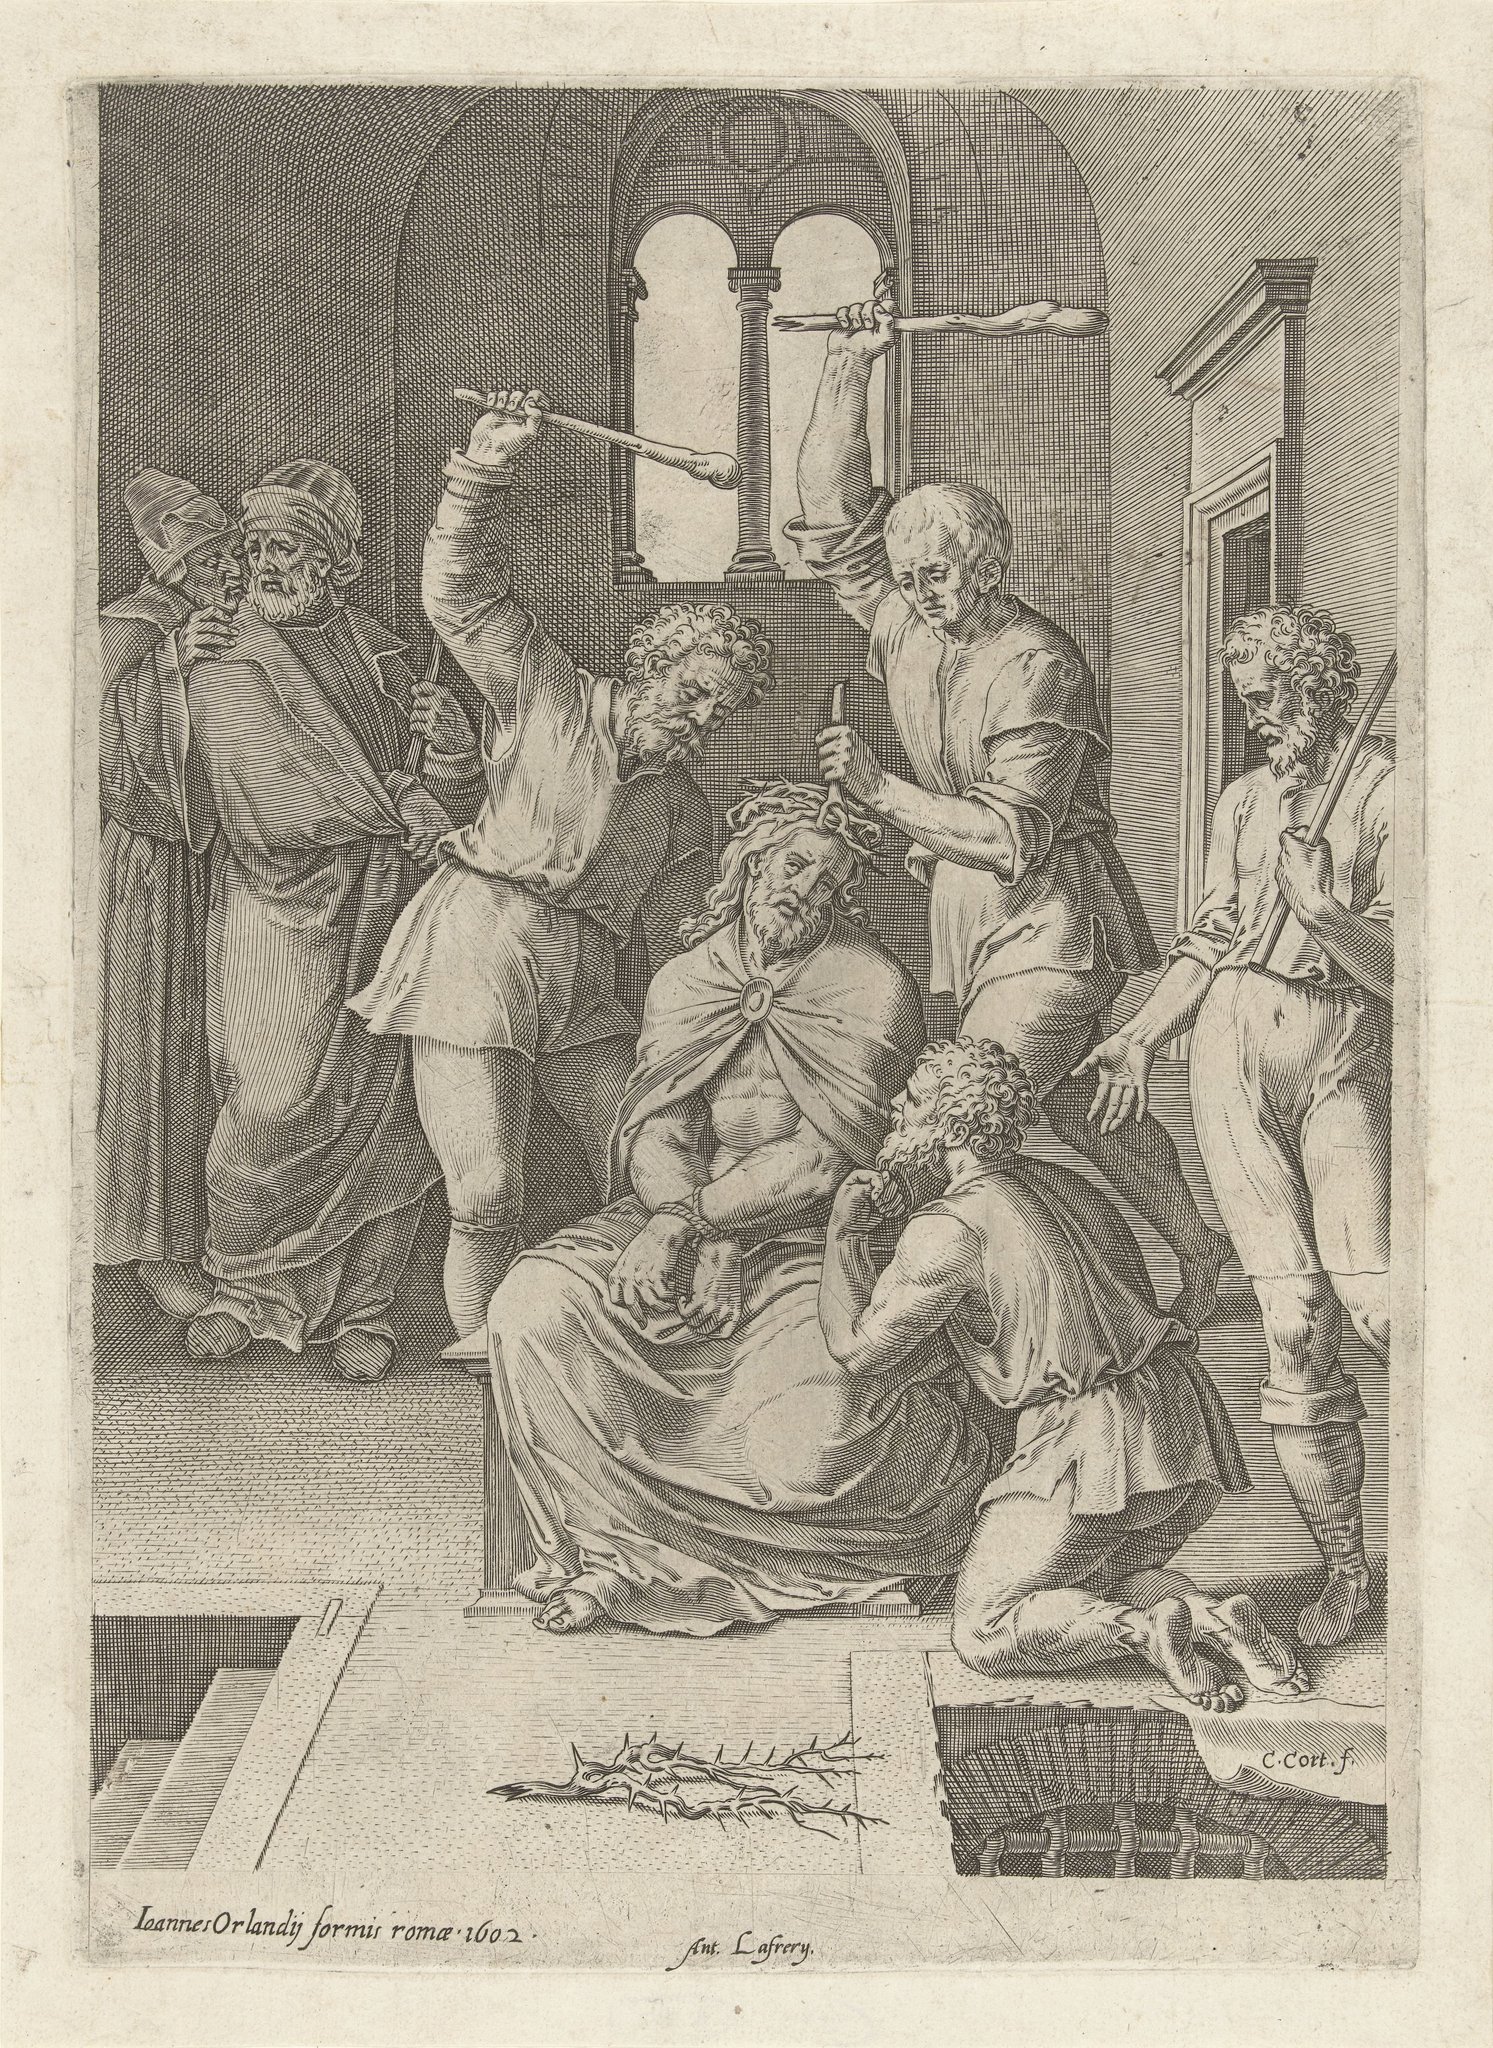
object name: print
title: De doornenkroning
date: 1602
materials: paper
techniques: engraving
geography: rome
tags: the crowning with thorns: soldiers with sticks place a thorny crown on christ's head and give him a reed (matthew 27:27-31; mark 15:16-20; john 19:2-3)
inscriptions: date: ‘1602’, collector's mark: Lugt 2228, signature: ‘gegraveerd’, address: ‘Ioannes Orlandij formis romae.’, address: ‘Ant. Lafrery.’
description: In een vertrek met romaans venster zit Christus met gebonden handen. Twee mannen slaan hem de doornenkroon op het hoofd, een man zit geknield voor hem. Drie andere mannen kijken naar het geheel. Op de grond een tak met doornen.